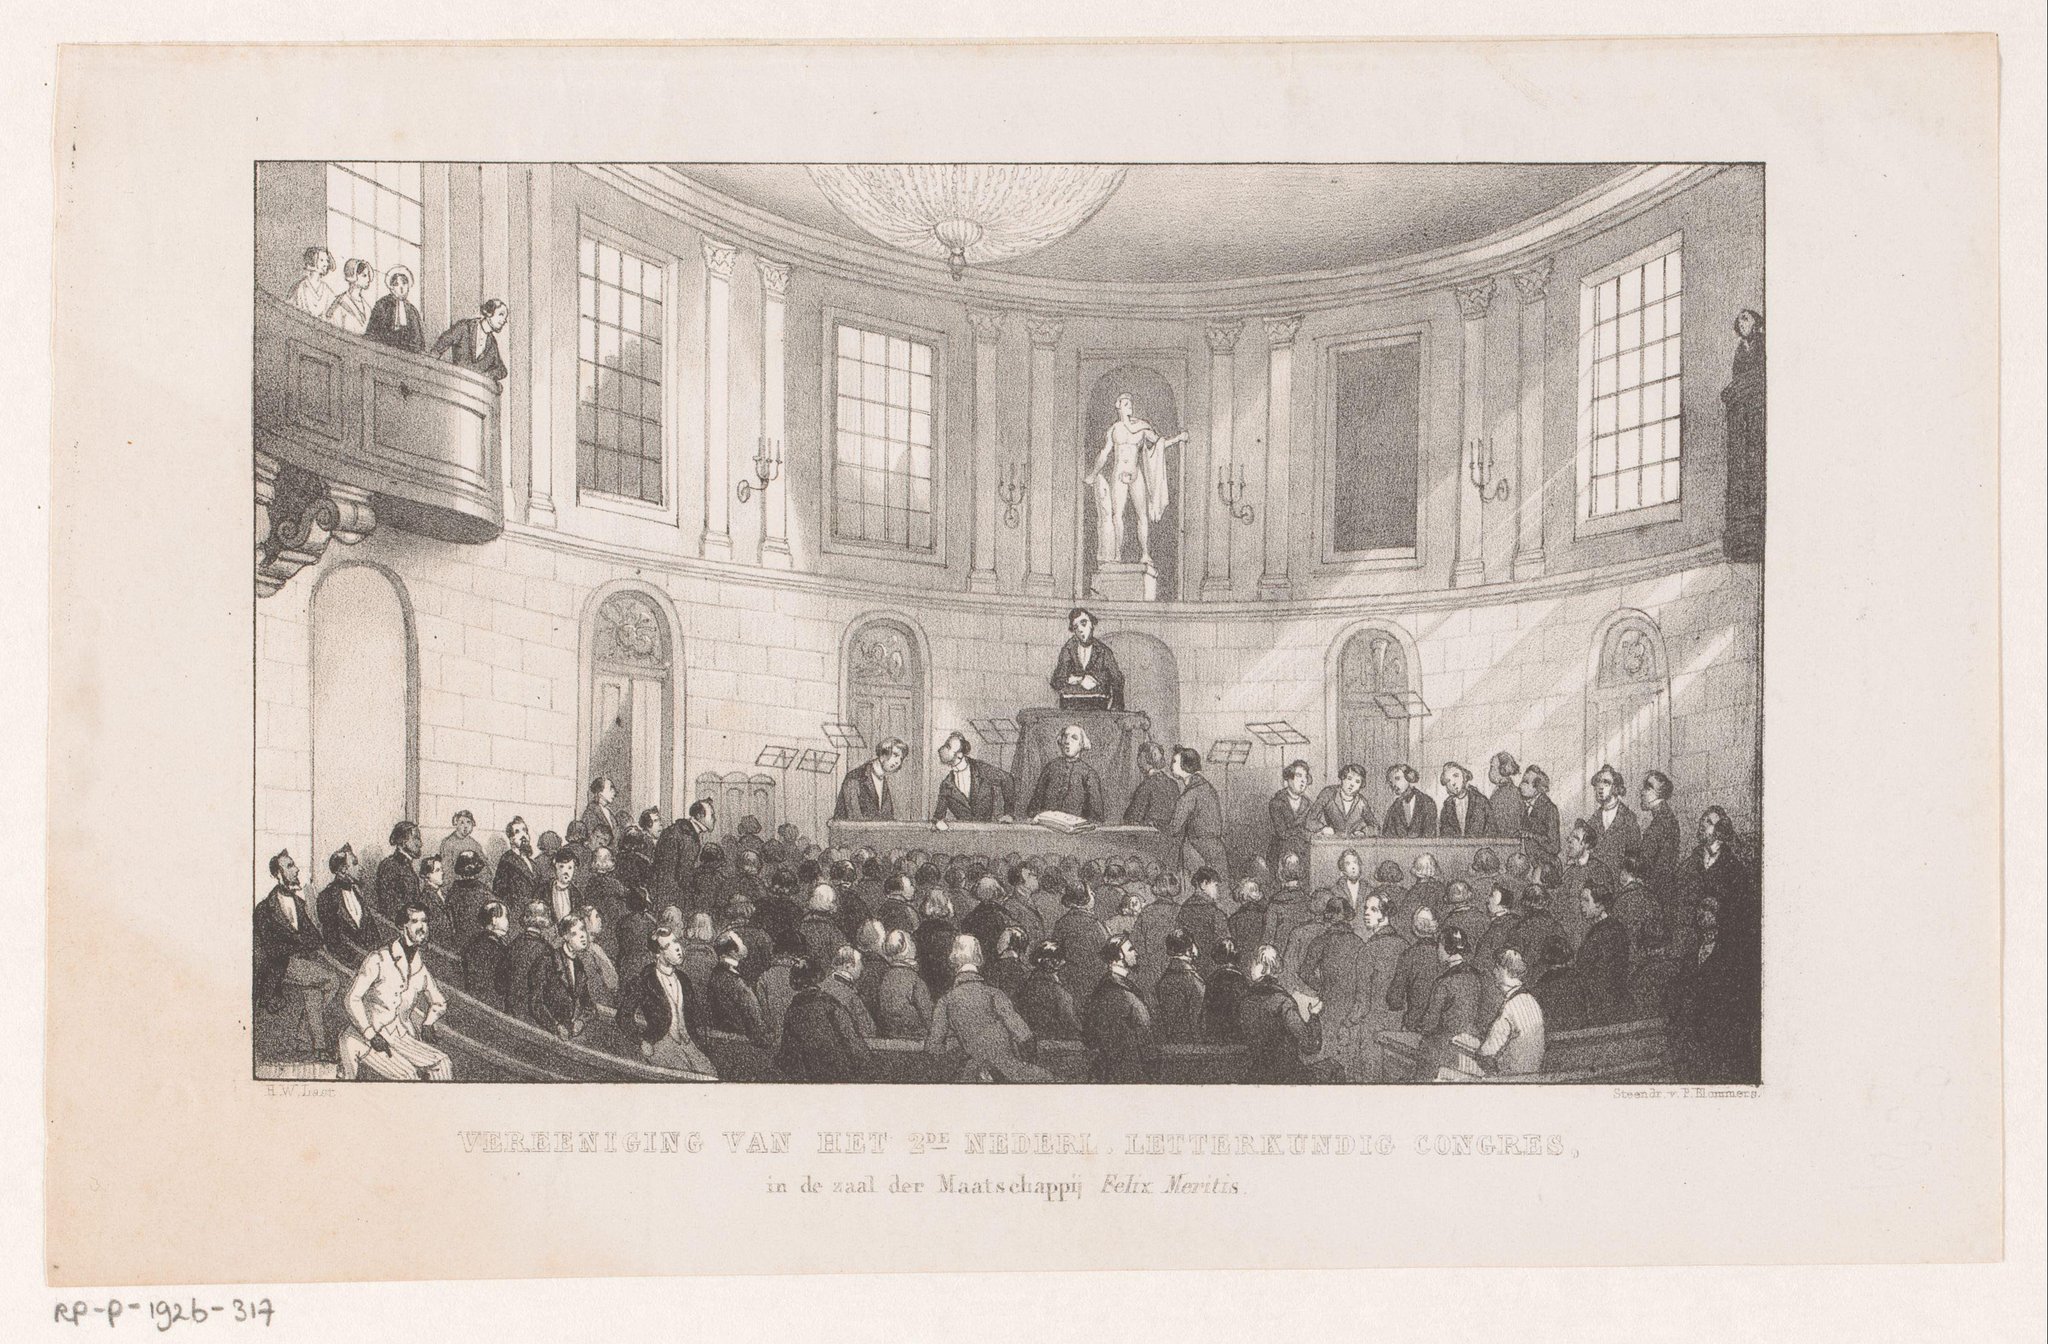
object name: print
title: Vereeniging van het 2de Nederl. letterkundig congres in de zaal der maatschappij Felix Meritis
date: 1850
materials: paper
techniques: lithograph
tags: meeting, assembly, linguistics, discussion, dialogue, dispute ~ scholar, philosopher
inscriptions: collector's mark: Lugt 2166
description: Bijeenkomst van het Tweede Nederlandsch Letterkundig Congres, in de Concertzaal van Felix Meritis te Amsterdam, van 16 tot en met 18 september 1850.